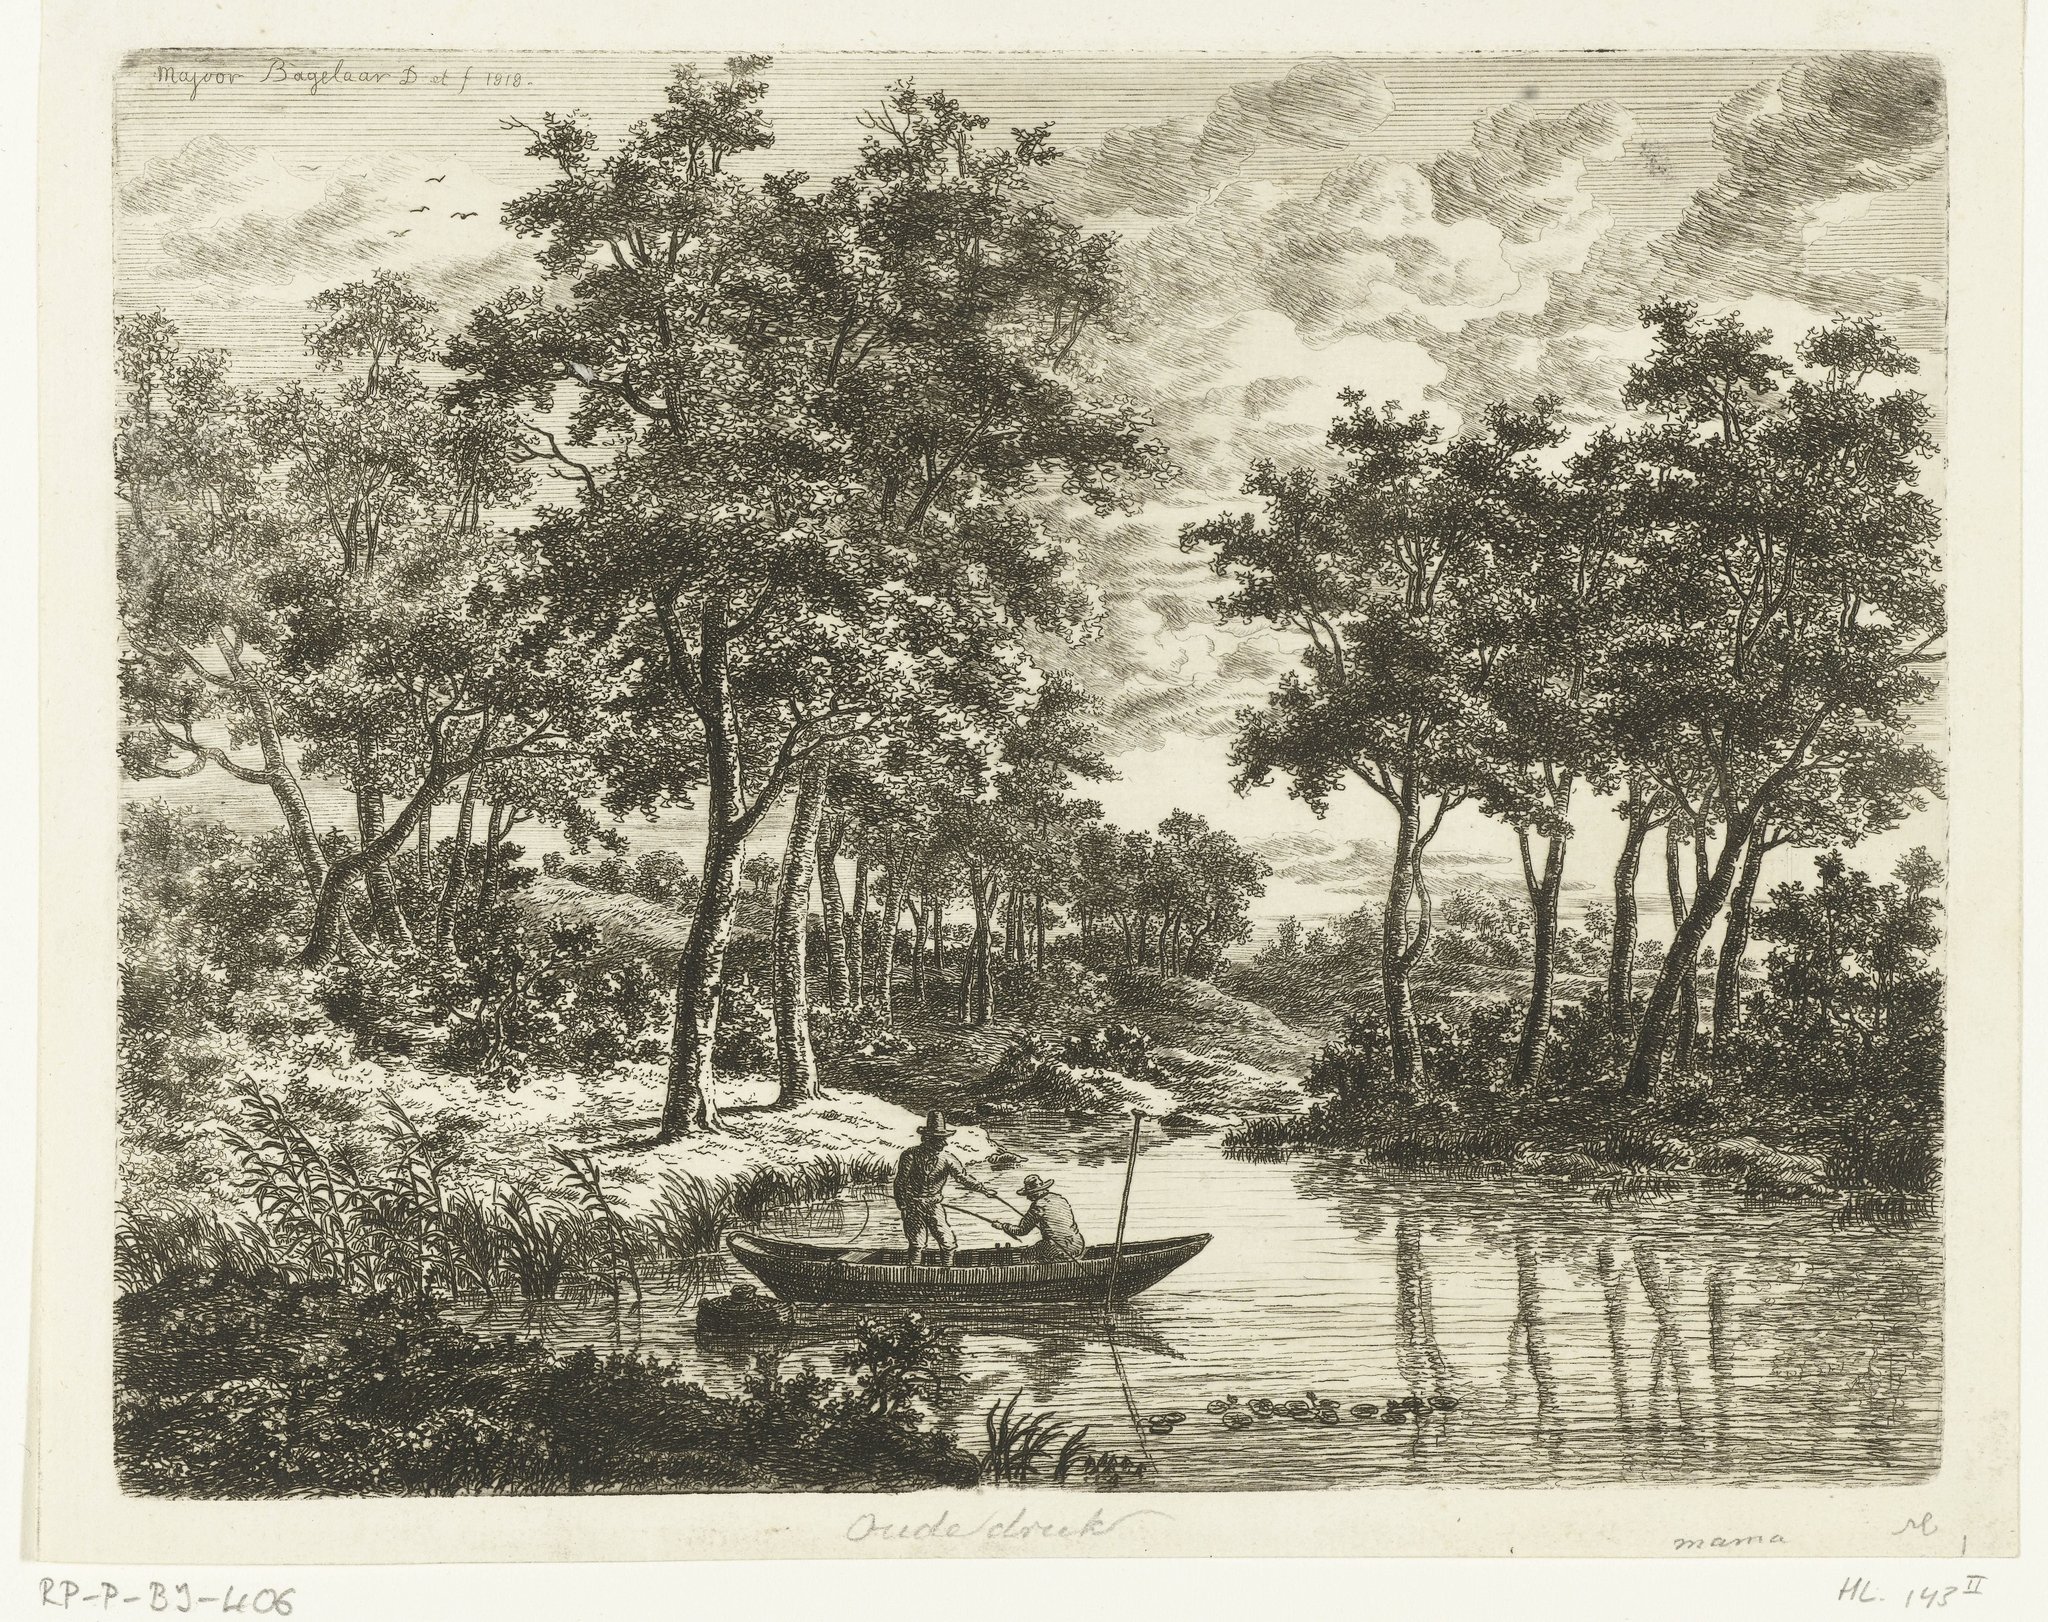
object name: print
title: Landschap met twee hengelende vissers in een boot op een vijver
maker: ernst willem jan bagelaar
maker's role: draughtsman, print maker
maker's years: 1775-1837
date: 1818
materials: paper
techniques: drypoint, etching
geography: netherlands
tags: pond, pool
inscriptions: collector's mark: Lugt 2228